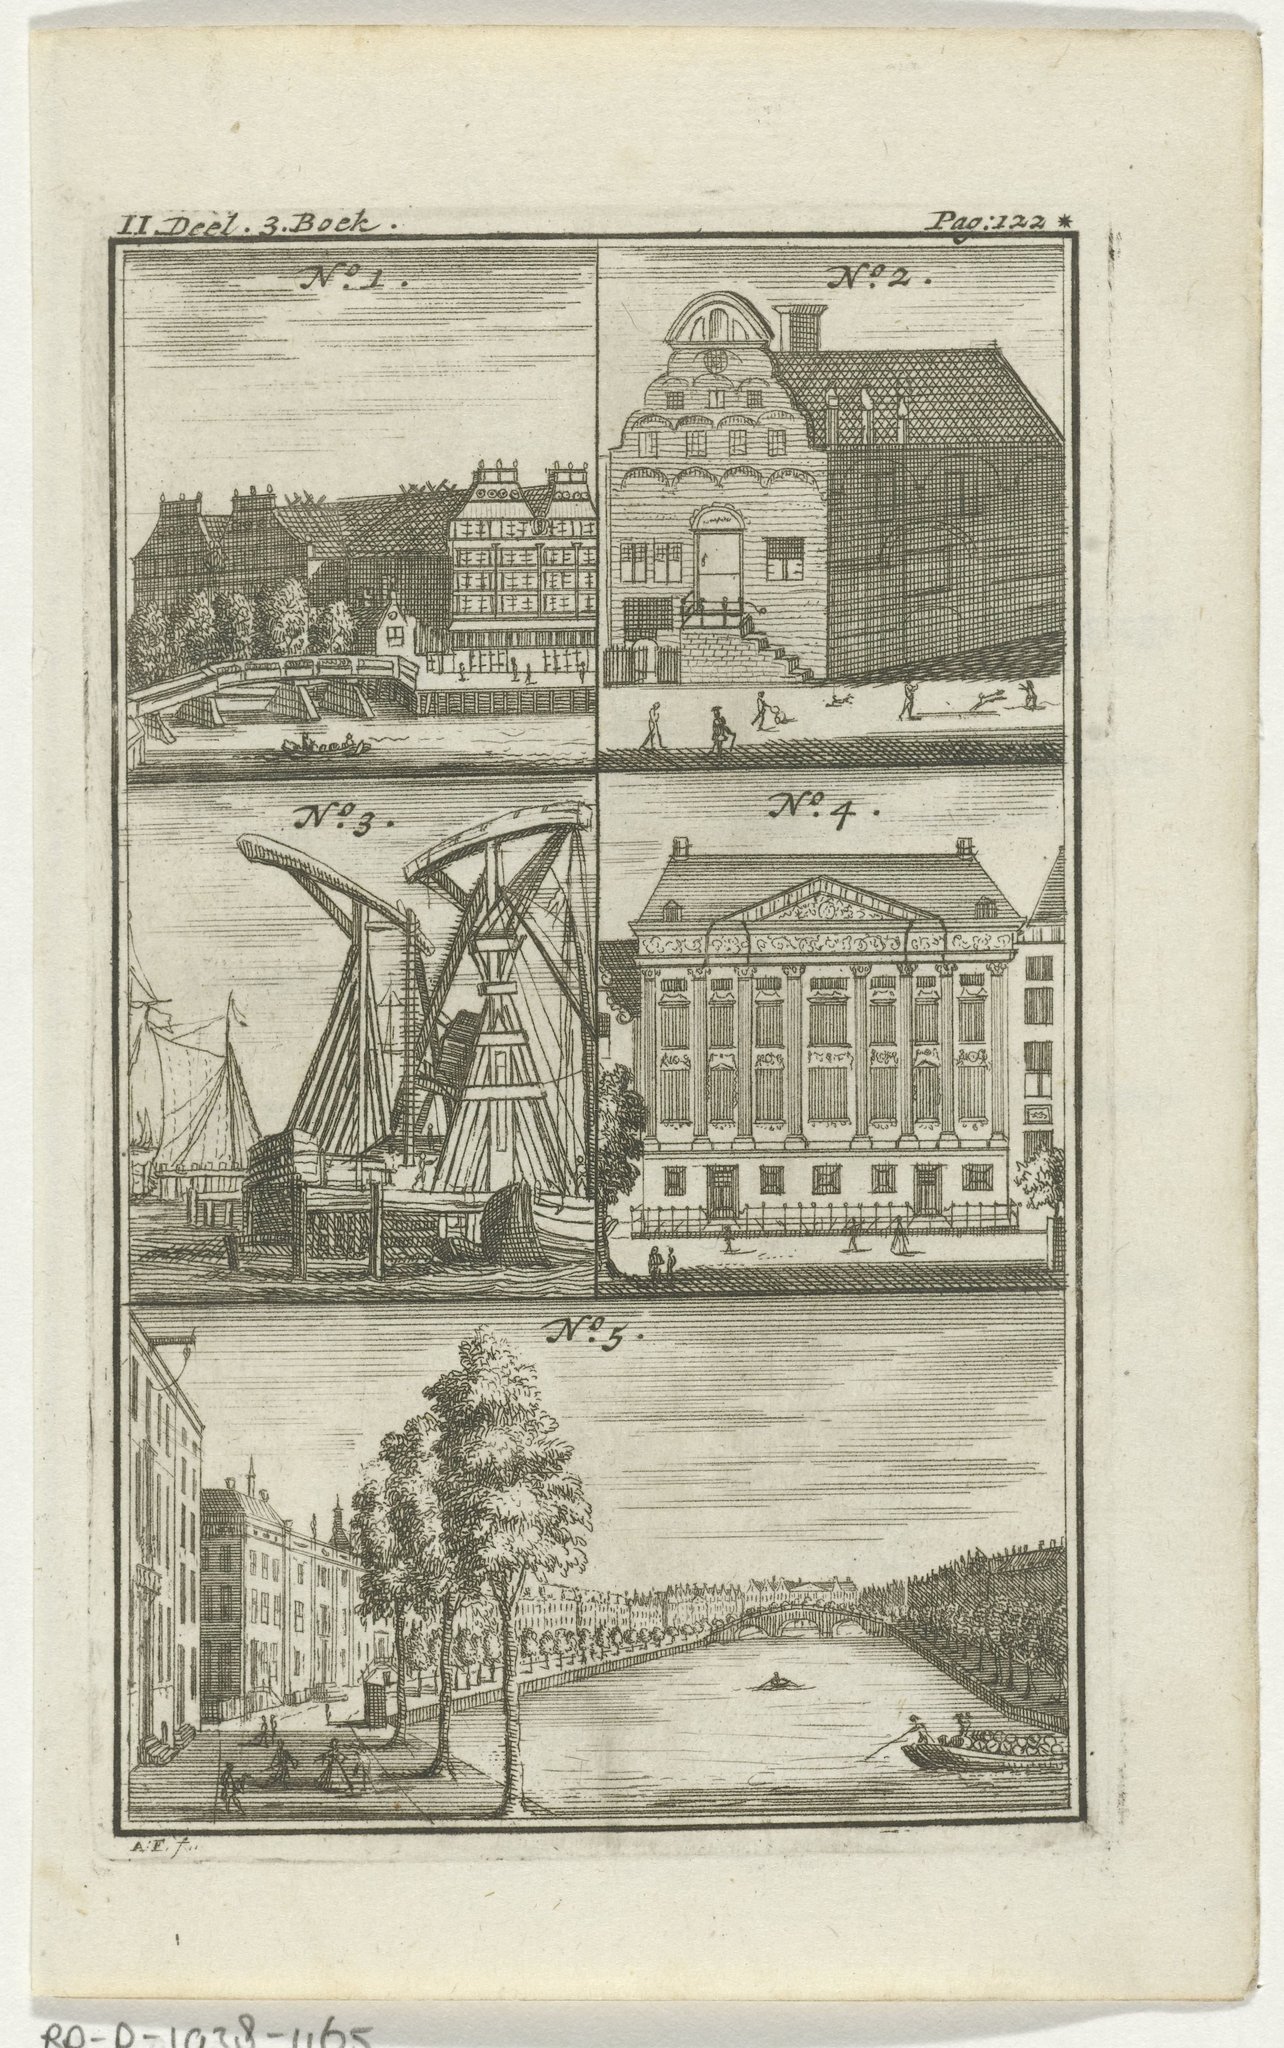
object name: print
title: Verschillende gebouwen en gezichten te Amsterdam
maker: anna folkema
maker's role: draughtsman, print maker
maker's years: 1695-1768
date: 1723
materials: paper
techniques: etching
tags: city-view in general; 'veduta', civic architecture; edifices; dwellings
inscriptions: collector's mark: Lugt 2760, collector's mark: Lugt 2228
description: Drie genummerde gebouwen en gezichten te Amsterdam: Stadsartillerie- en Korenhuizen, makelaarskantoor op de Nieuwezijds Voorburgwal, scheepskranen aan het IJ, Trippenhuis, gezicht op de Gouden bocht van de Herengracht. De gebouwen en gezichten zijn op het bijbehorende tekstblad voorzien van toelichting. Prent links- en rechtsboven gemerkt: II. Deel. 3. Boek - Pag: 122*.